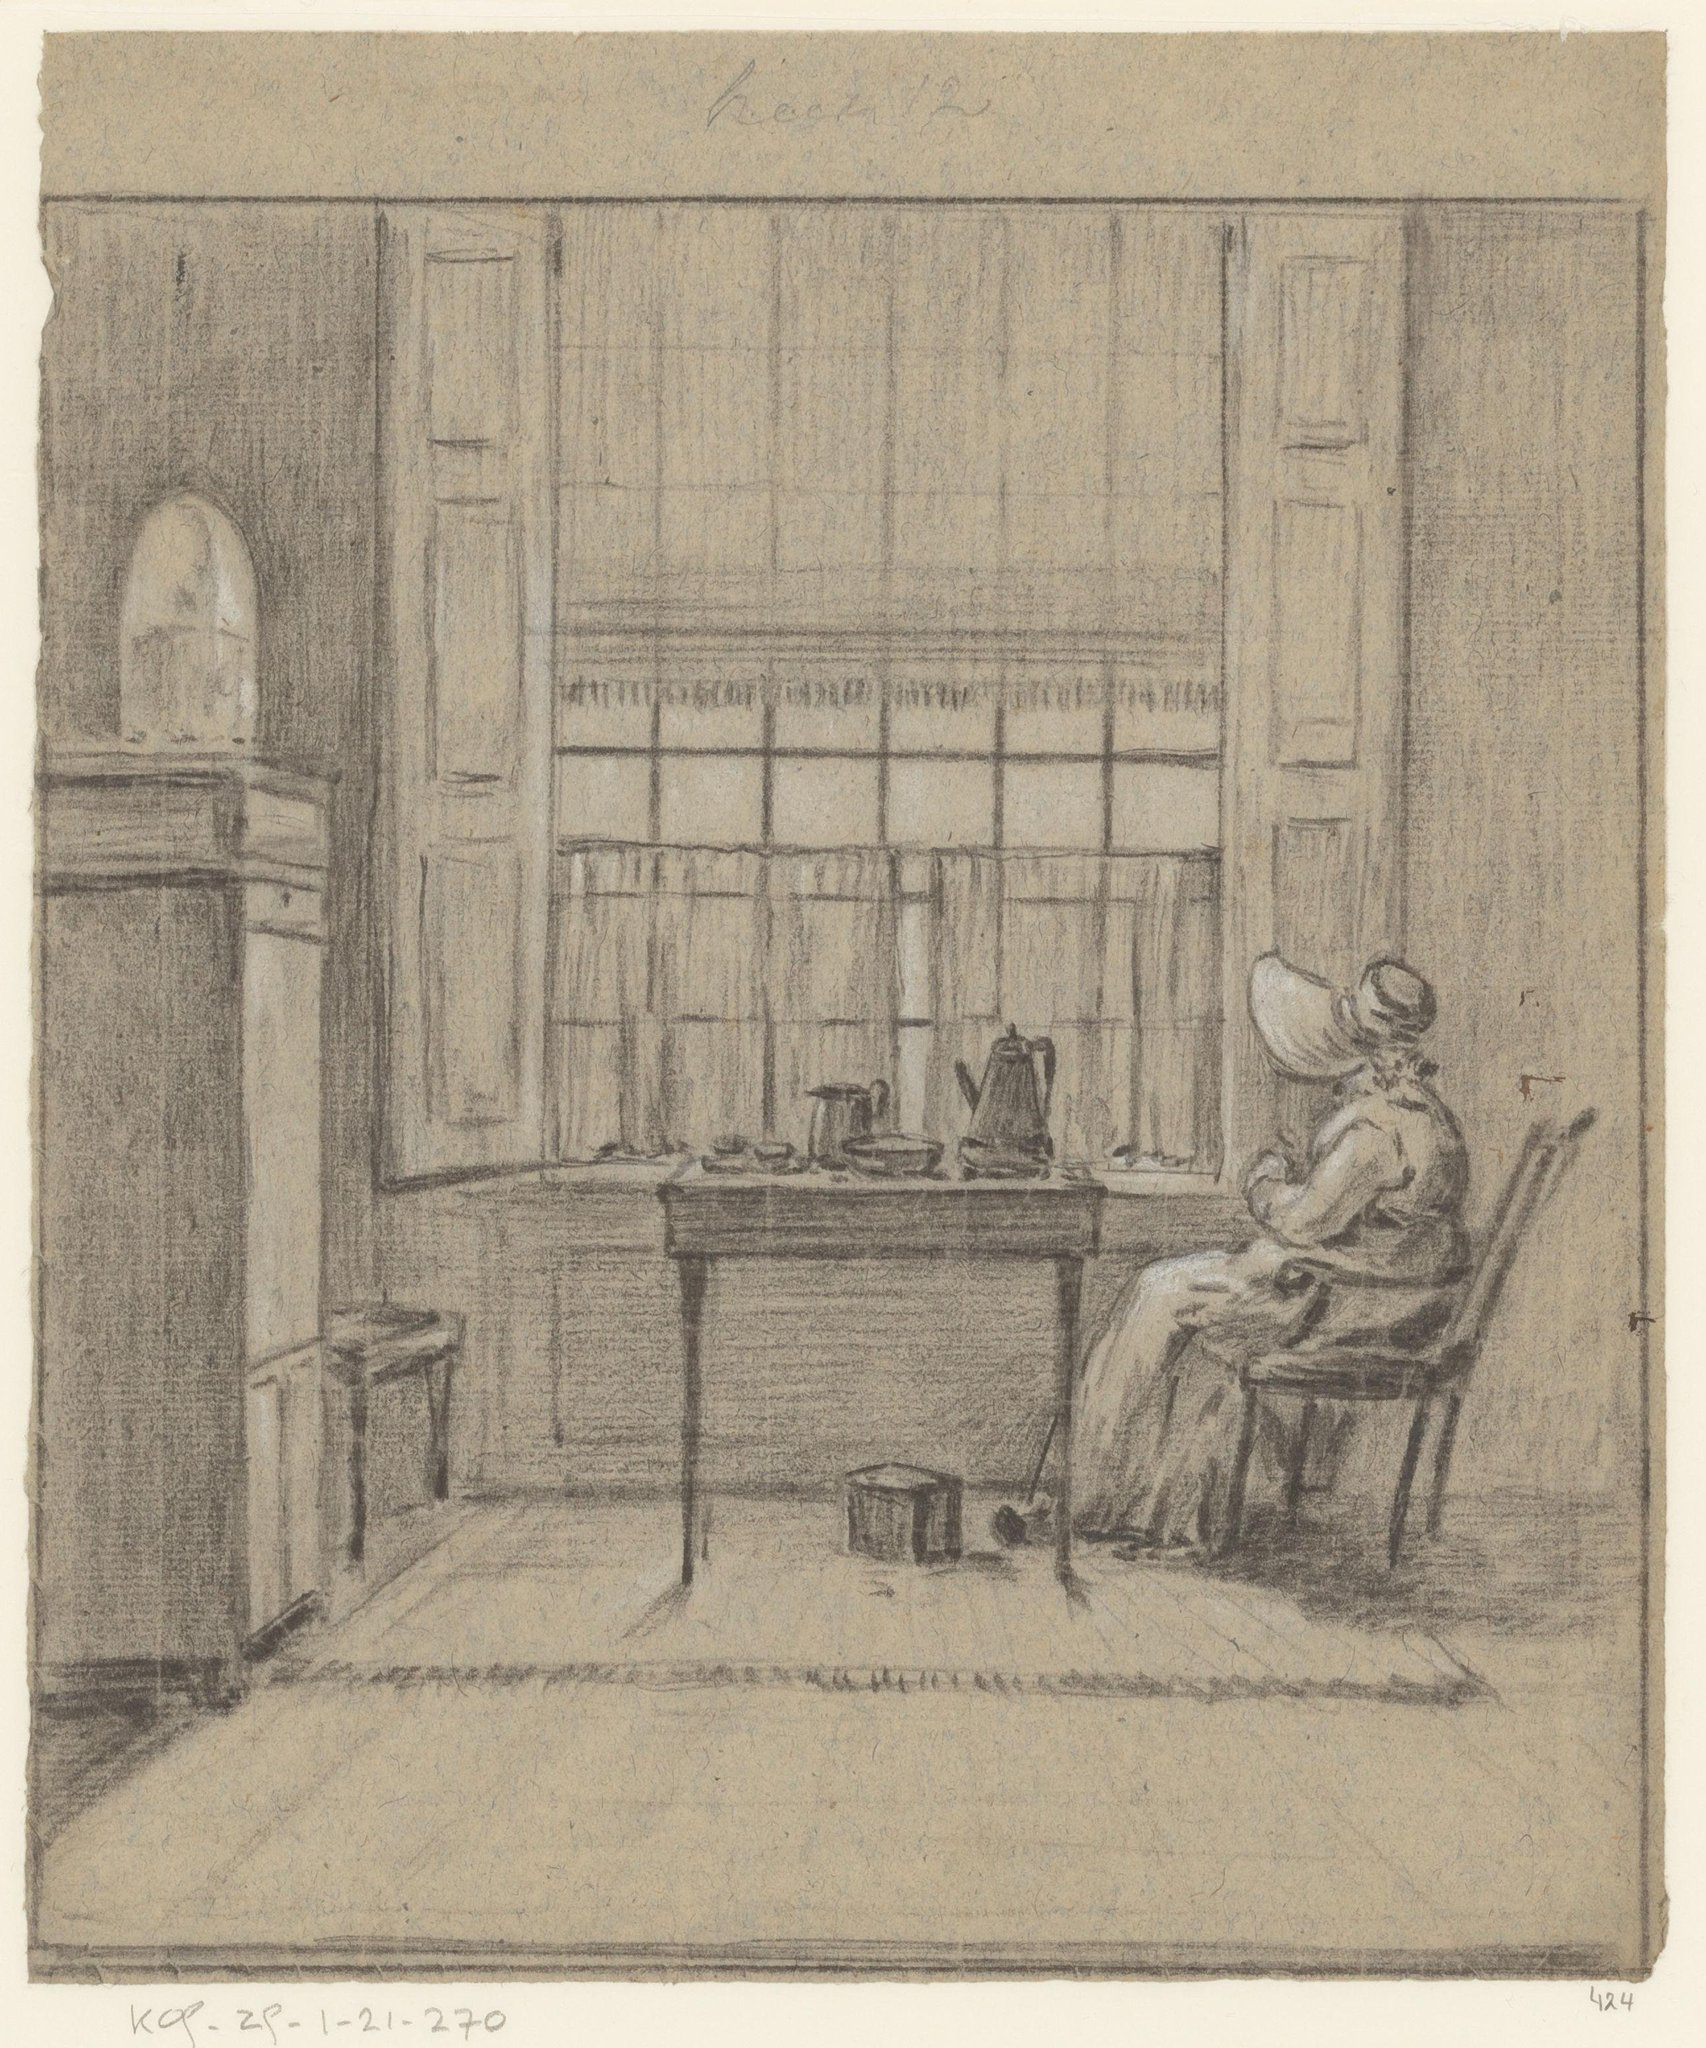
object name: drawing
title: Breiende vrouw zit bij een koffietafel bij het raam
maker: jean bernard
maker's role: draughtsman, print maker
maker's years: 1765-1833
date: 1775-1833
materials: chalk, paper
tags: coffee-pot, window, sitting on an elevation - aa - female human figure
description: Onderwerpsrubrieken binnen de Atlas Zeden en Gewoonten: Zeden en Gewoonten in Engeren Zin, De Kleeding, Kleederdrachten (tijdvakken), De regeering van Willem I. Mannen en vrouwen.